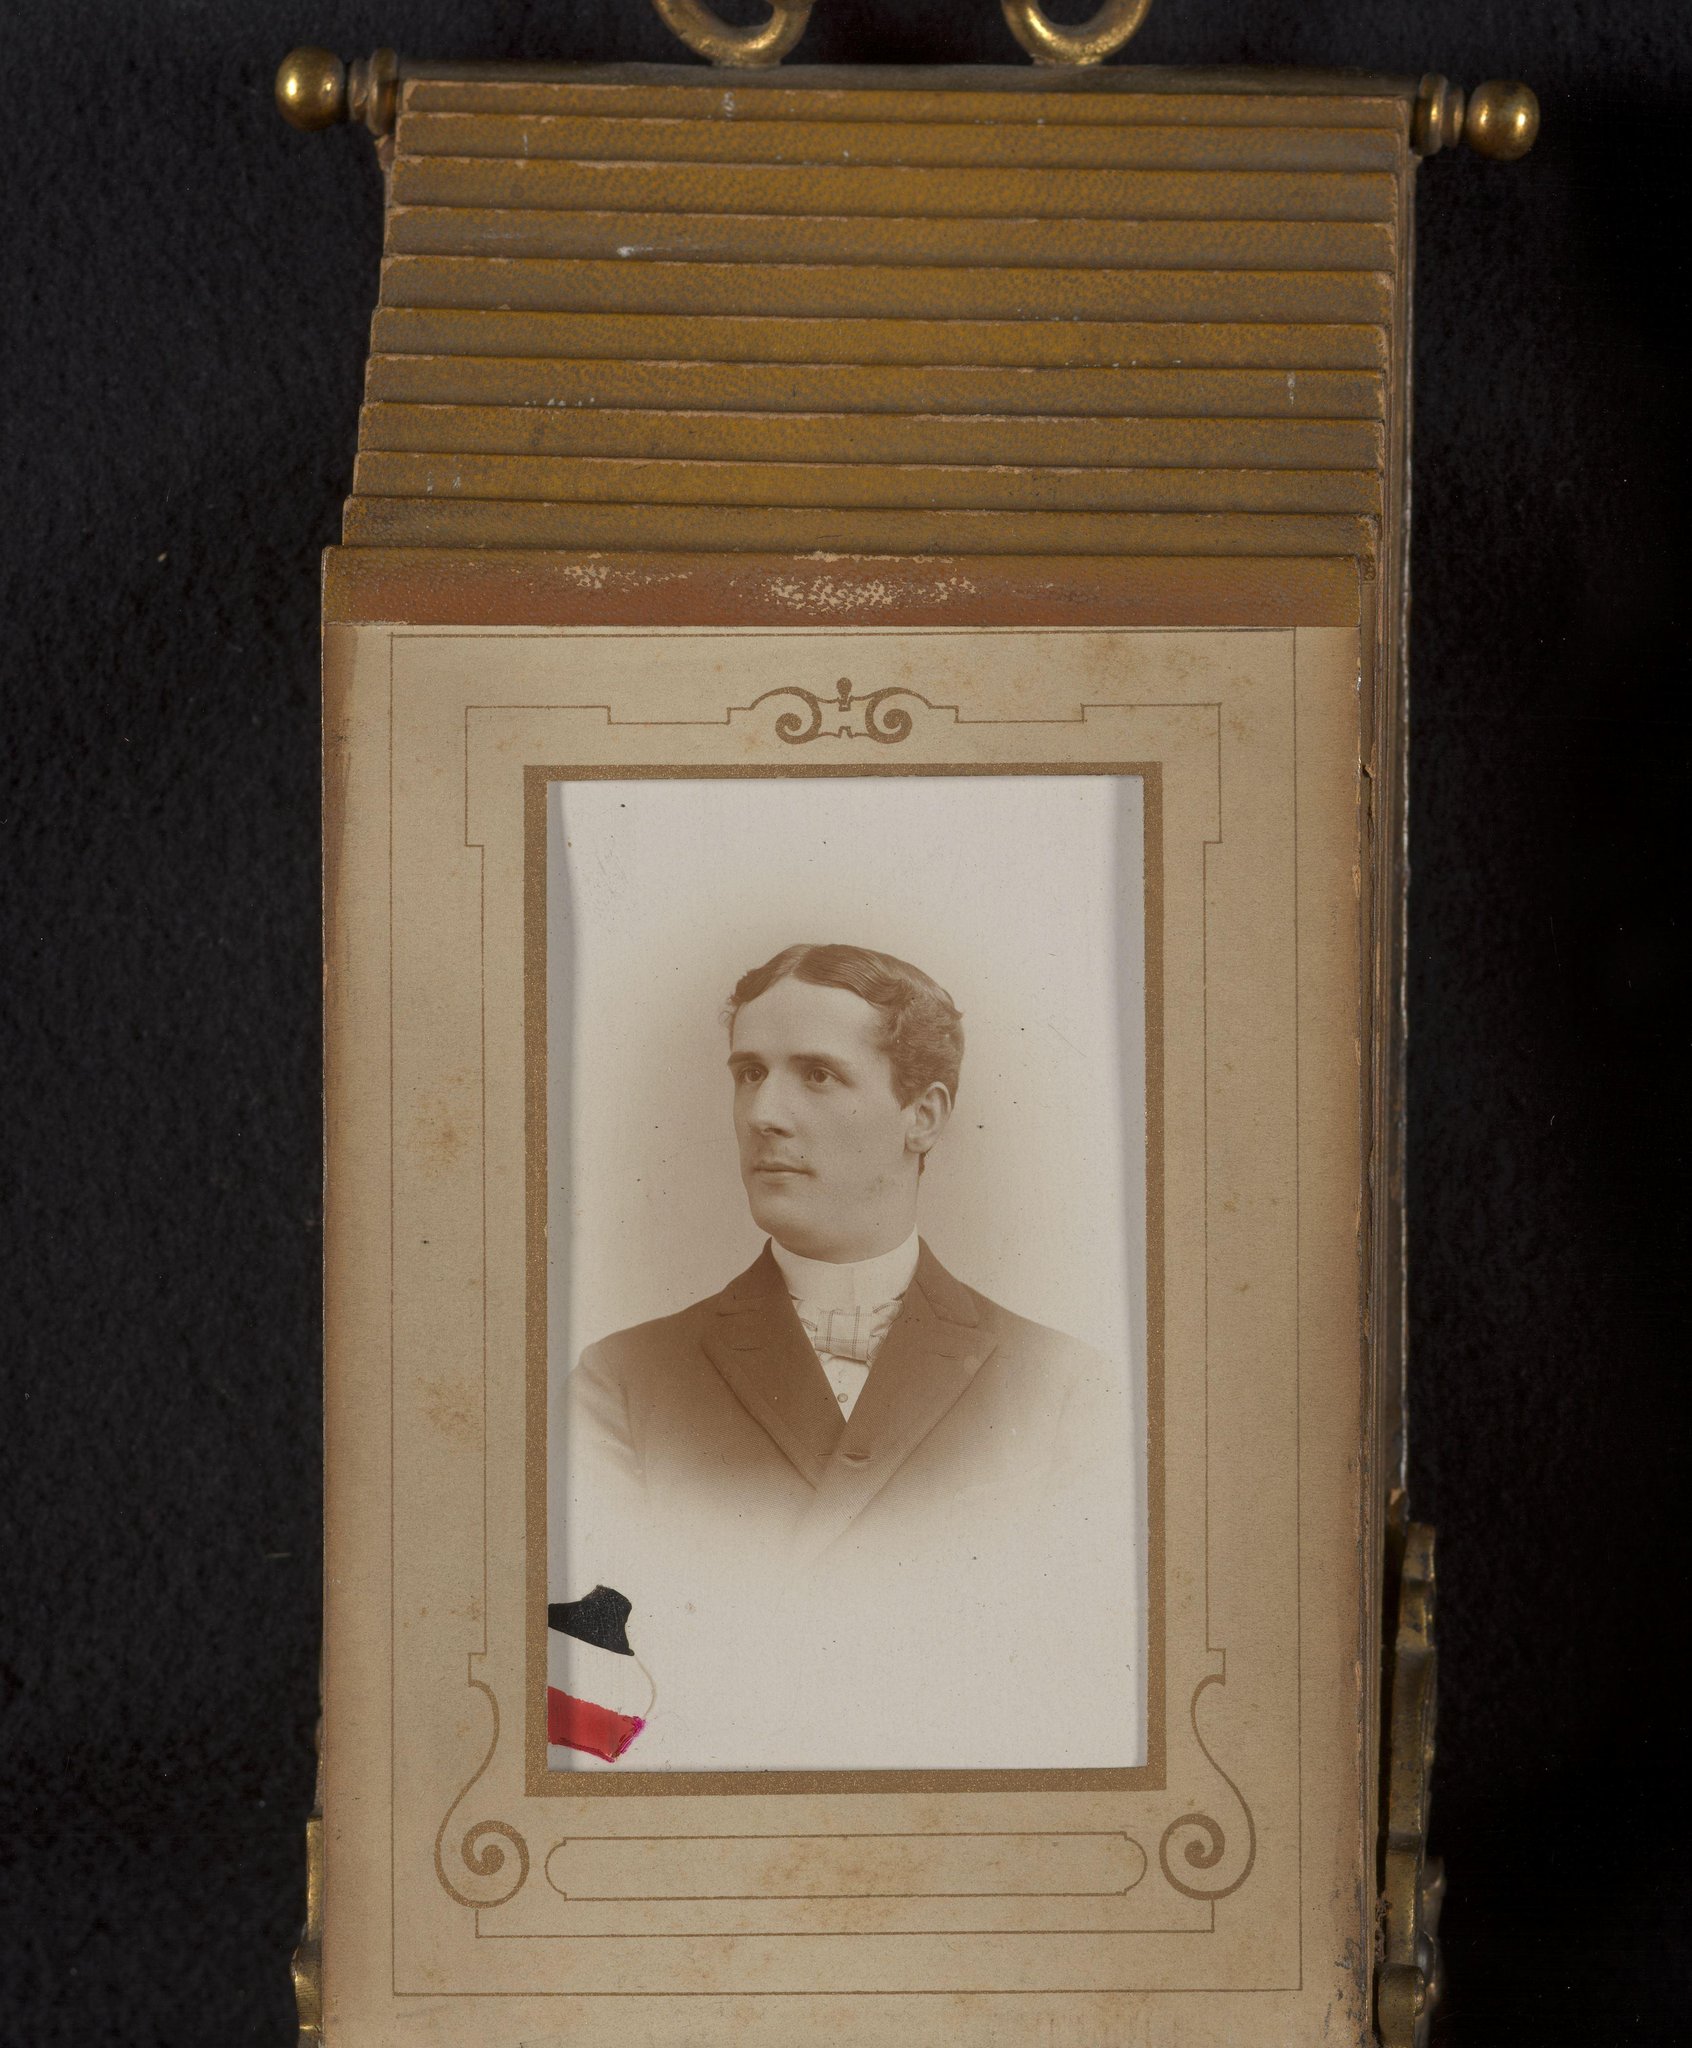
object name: carte de visite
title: Portret van een man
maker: Anonymous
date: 1893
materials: cardboard, photographic support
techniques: collodion silver print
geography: halle an der saale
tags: historical persons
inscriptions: inscription: ‘Paul Herb[...]/ Alter Dartk [...]/ Halle a/d [...]/ Die Platte bleibt für Nachbestell[ungen]/ aufgehoben.’, annotation: ‘[....]/ 8.9.93’